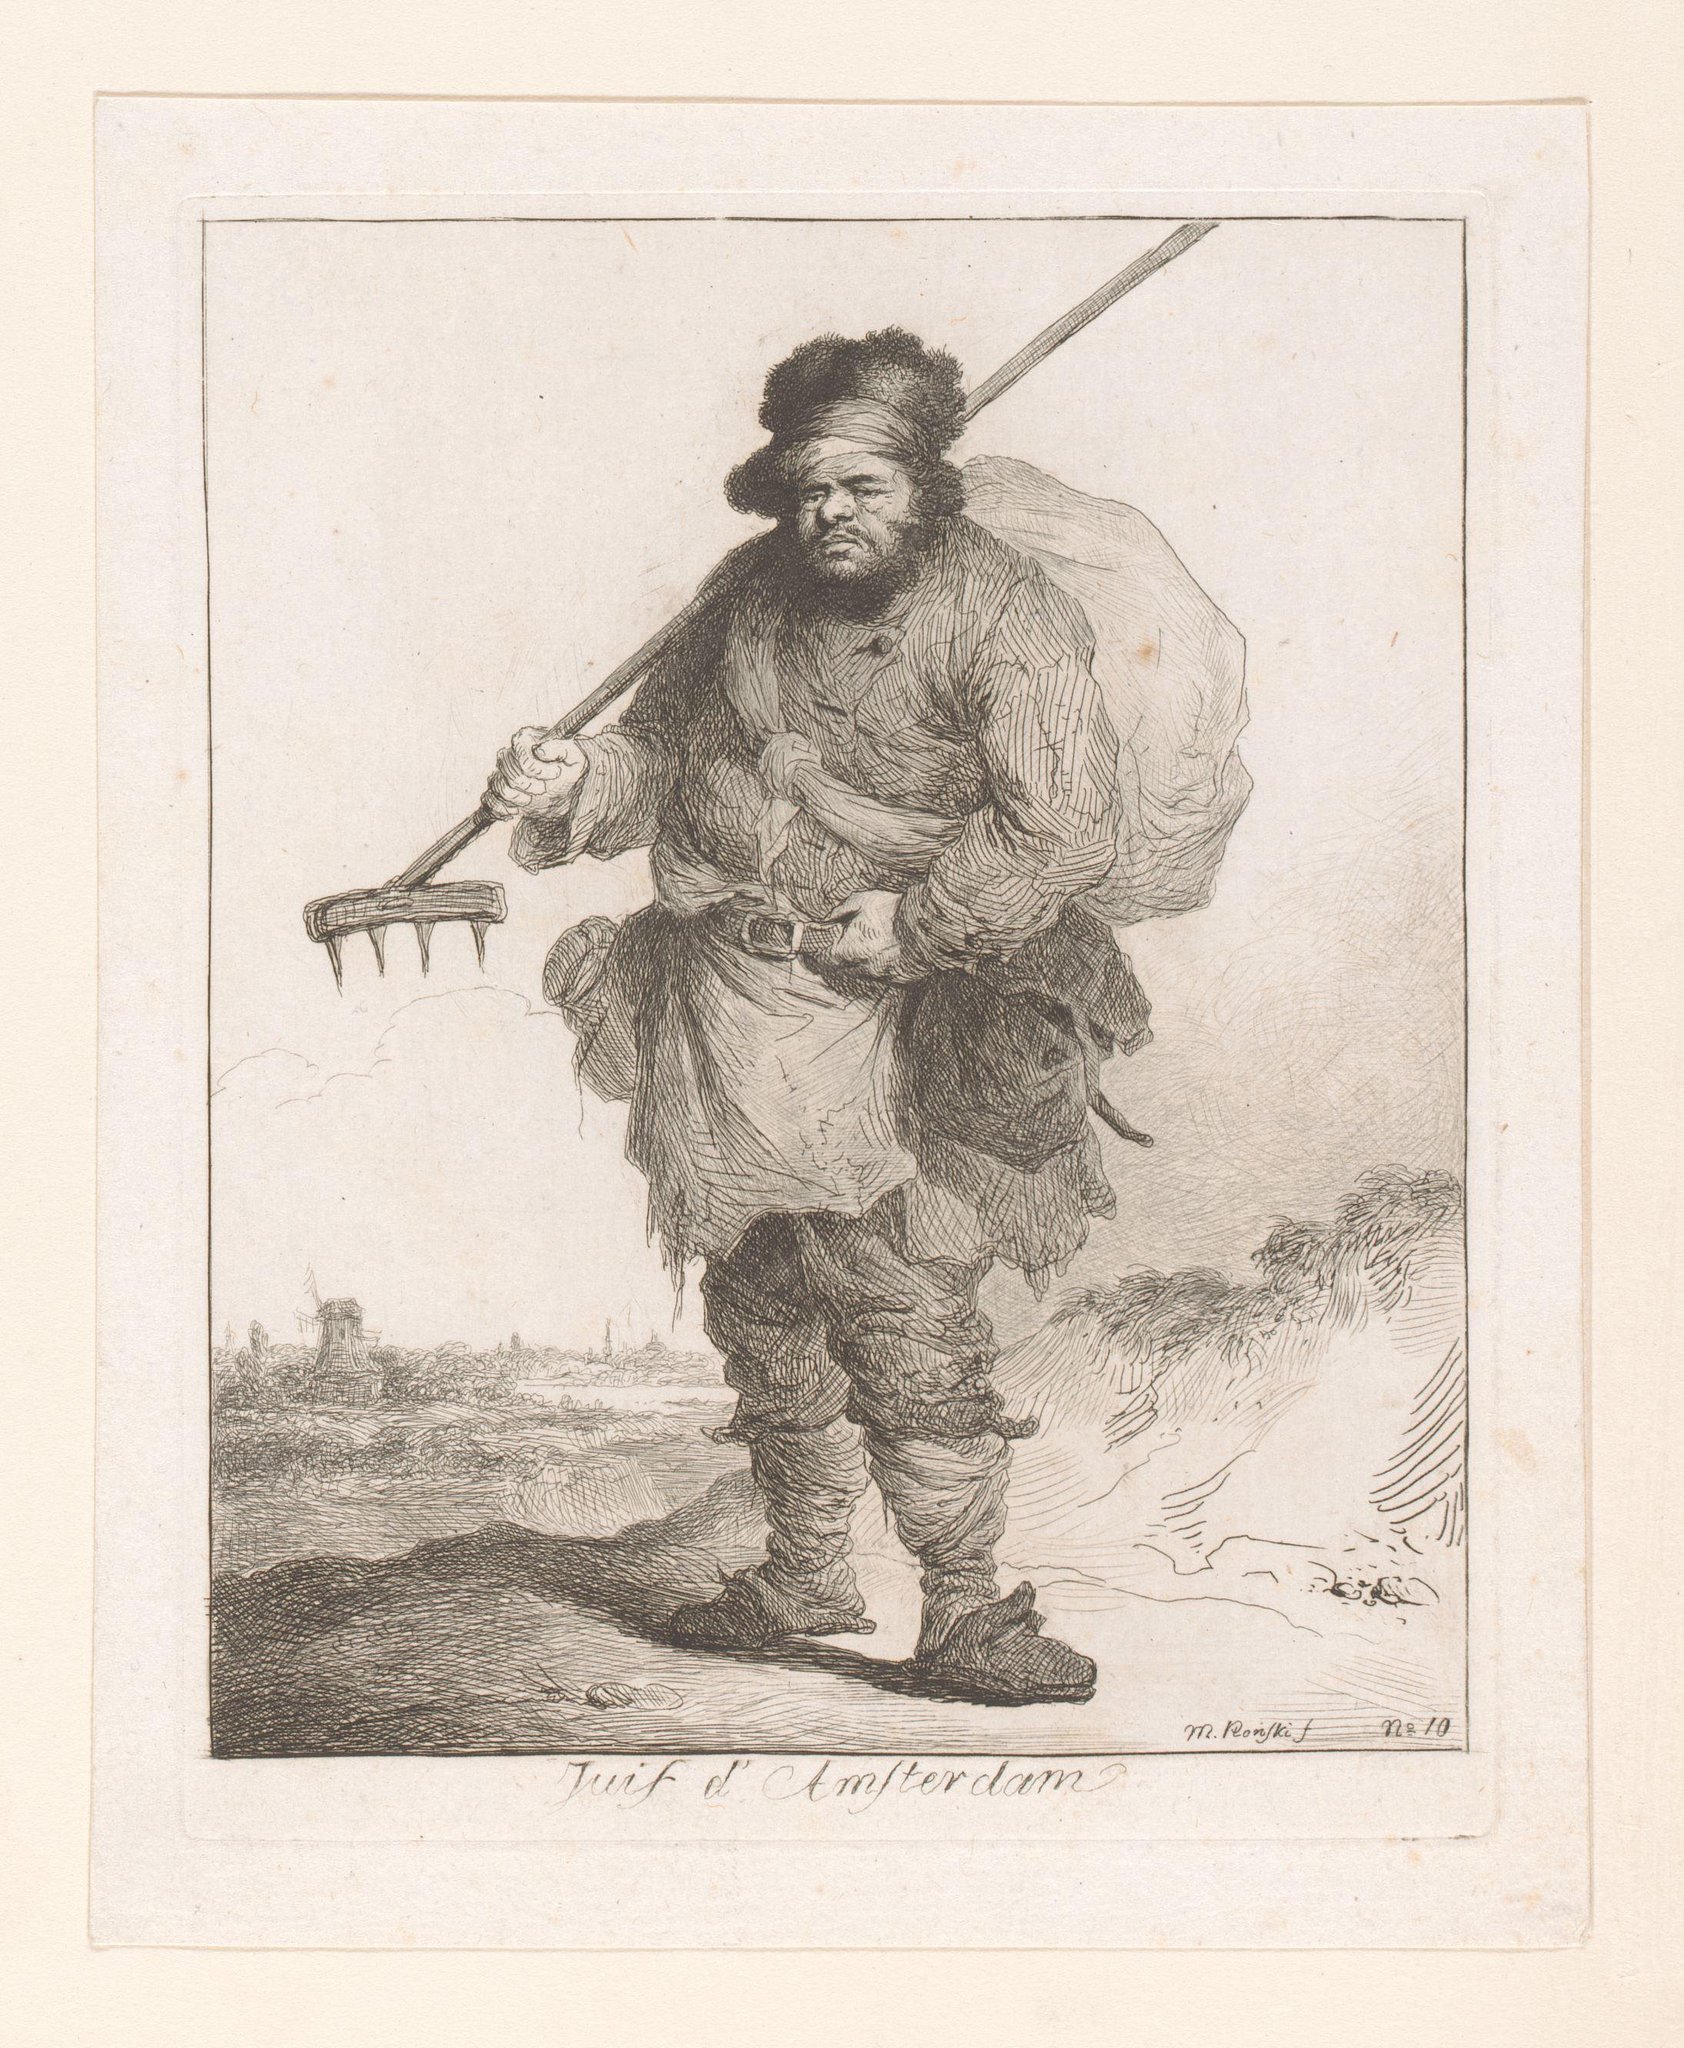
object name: print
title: Joodse man uit Amsterdam met plunjezak en riek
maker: michał płoński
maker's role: print maker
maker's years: 1778-1812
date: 1802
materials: paper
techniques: drypoint, etching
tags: adult man, the jews, jewish life, agricultural implements: rake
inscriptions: collector's mark: Lugt 2228